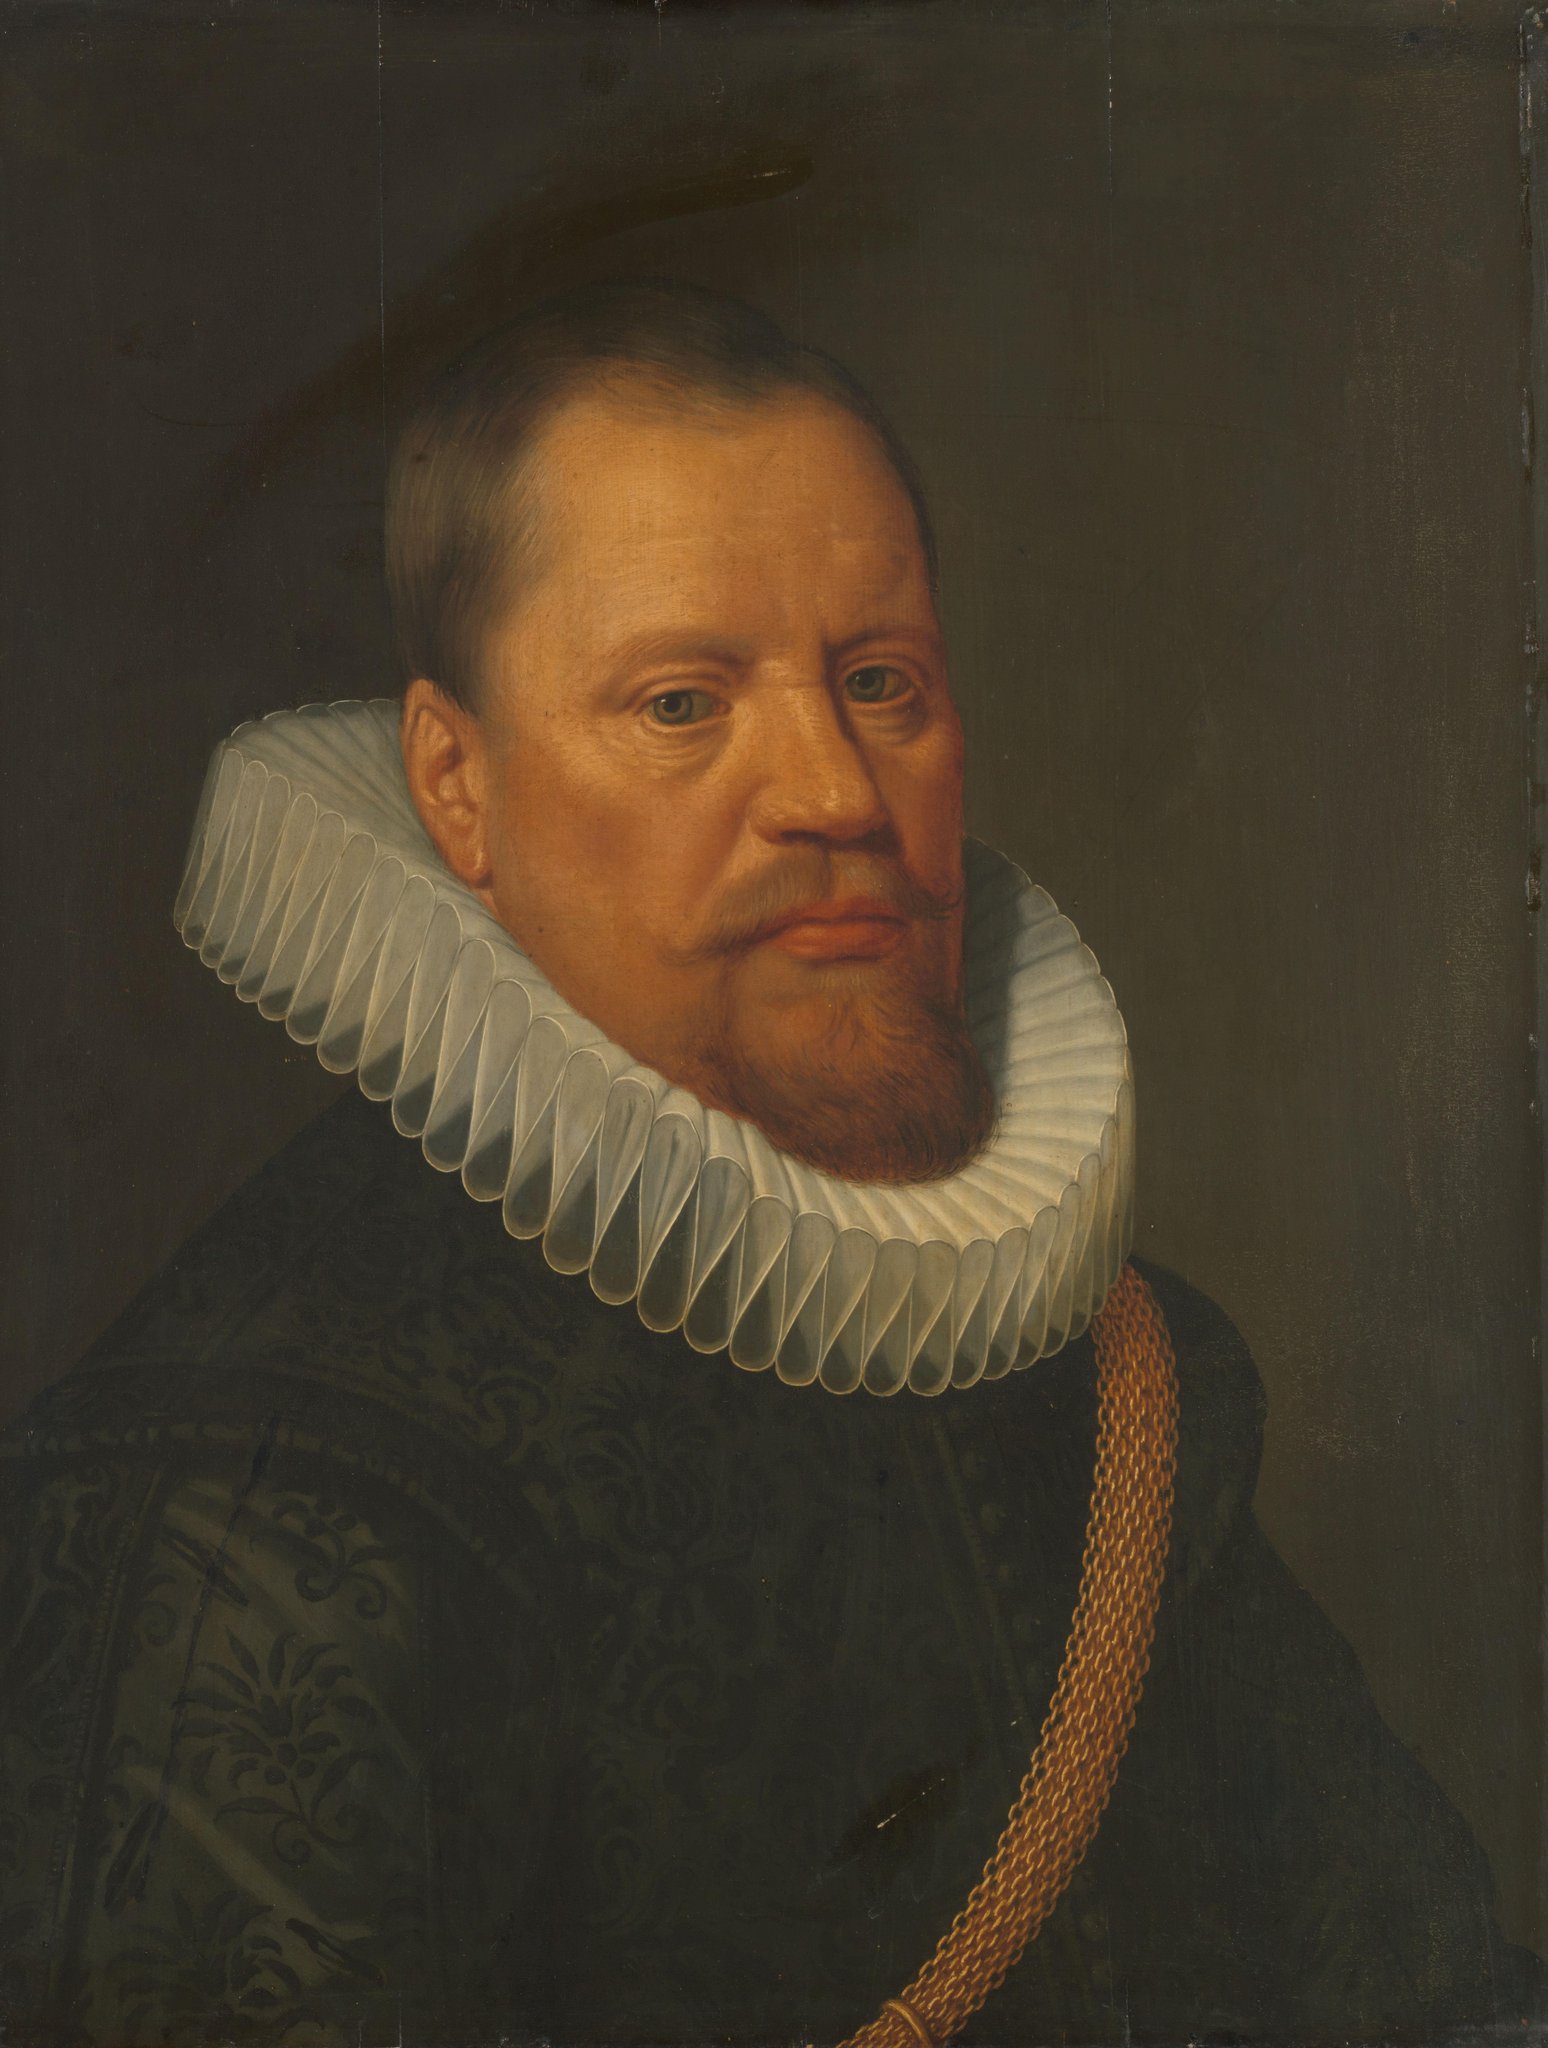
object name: painting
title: Portrait of a Man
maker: Anonymous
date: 1615-1620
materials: oil, panel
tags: flushing, historical persons, zeeland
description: Portret van een man. Buste naar rechts, een gouden ketting om de borst.